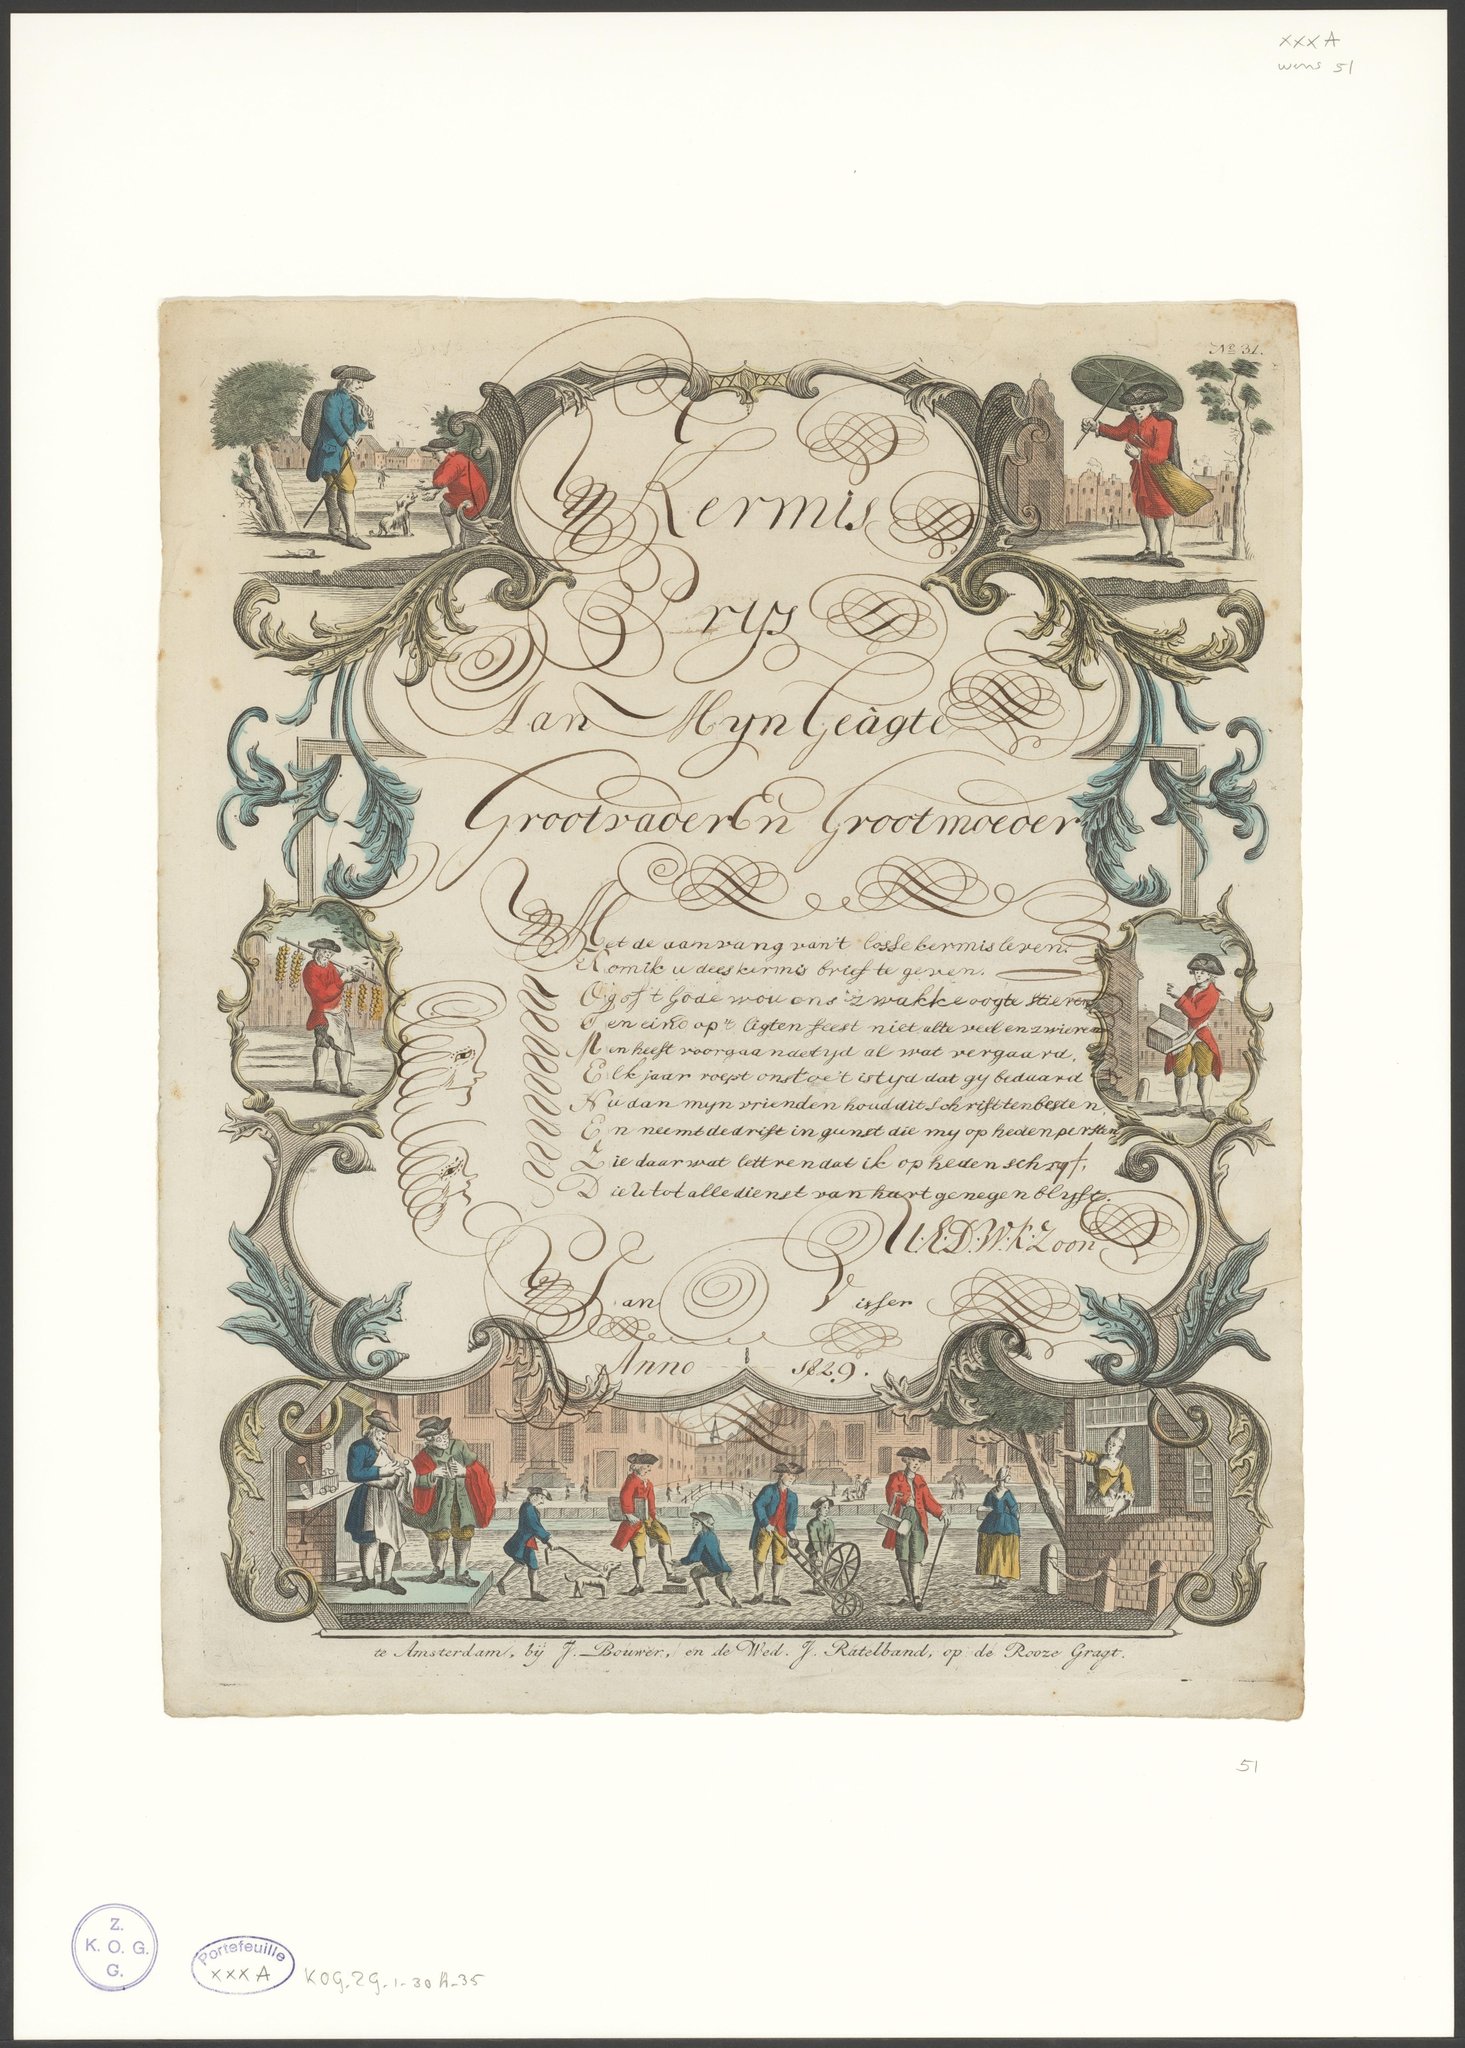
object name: print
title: Kermiswens van Jan Visscher, 1829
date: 1829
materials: ink, paper, watercolor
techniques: engraving, hand coloring, handwriting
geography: netherlands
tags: pedlar, pleasure fair and circus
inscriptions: collector's mark: Lugt 1641, collector's mark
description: Kermiswens van Jan Visscher, 1829. Gericht aan zijn grootvader en grootmoeder. Voorgedrukt blad met een kader gevormd door voorstellingen van marskramers en onderaan een straatgezicht met diverse figuren. Genummerd rechtsboven: No. 31. Onderwerpsrubrieken binnen de Atlas Zeden en Gewoonten: Nieuwjaars- en kermiswenschen.